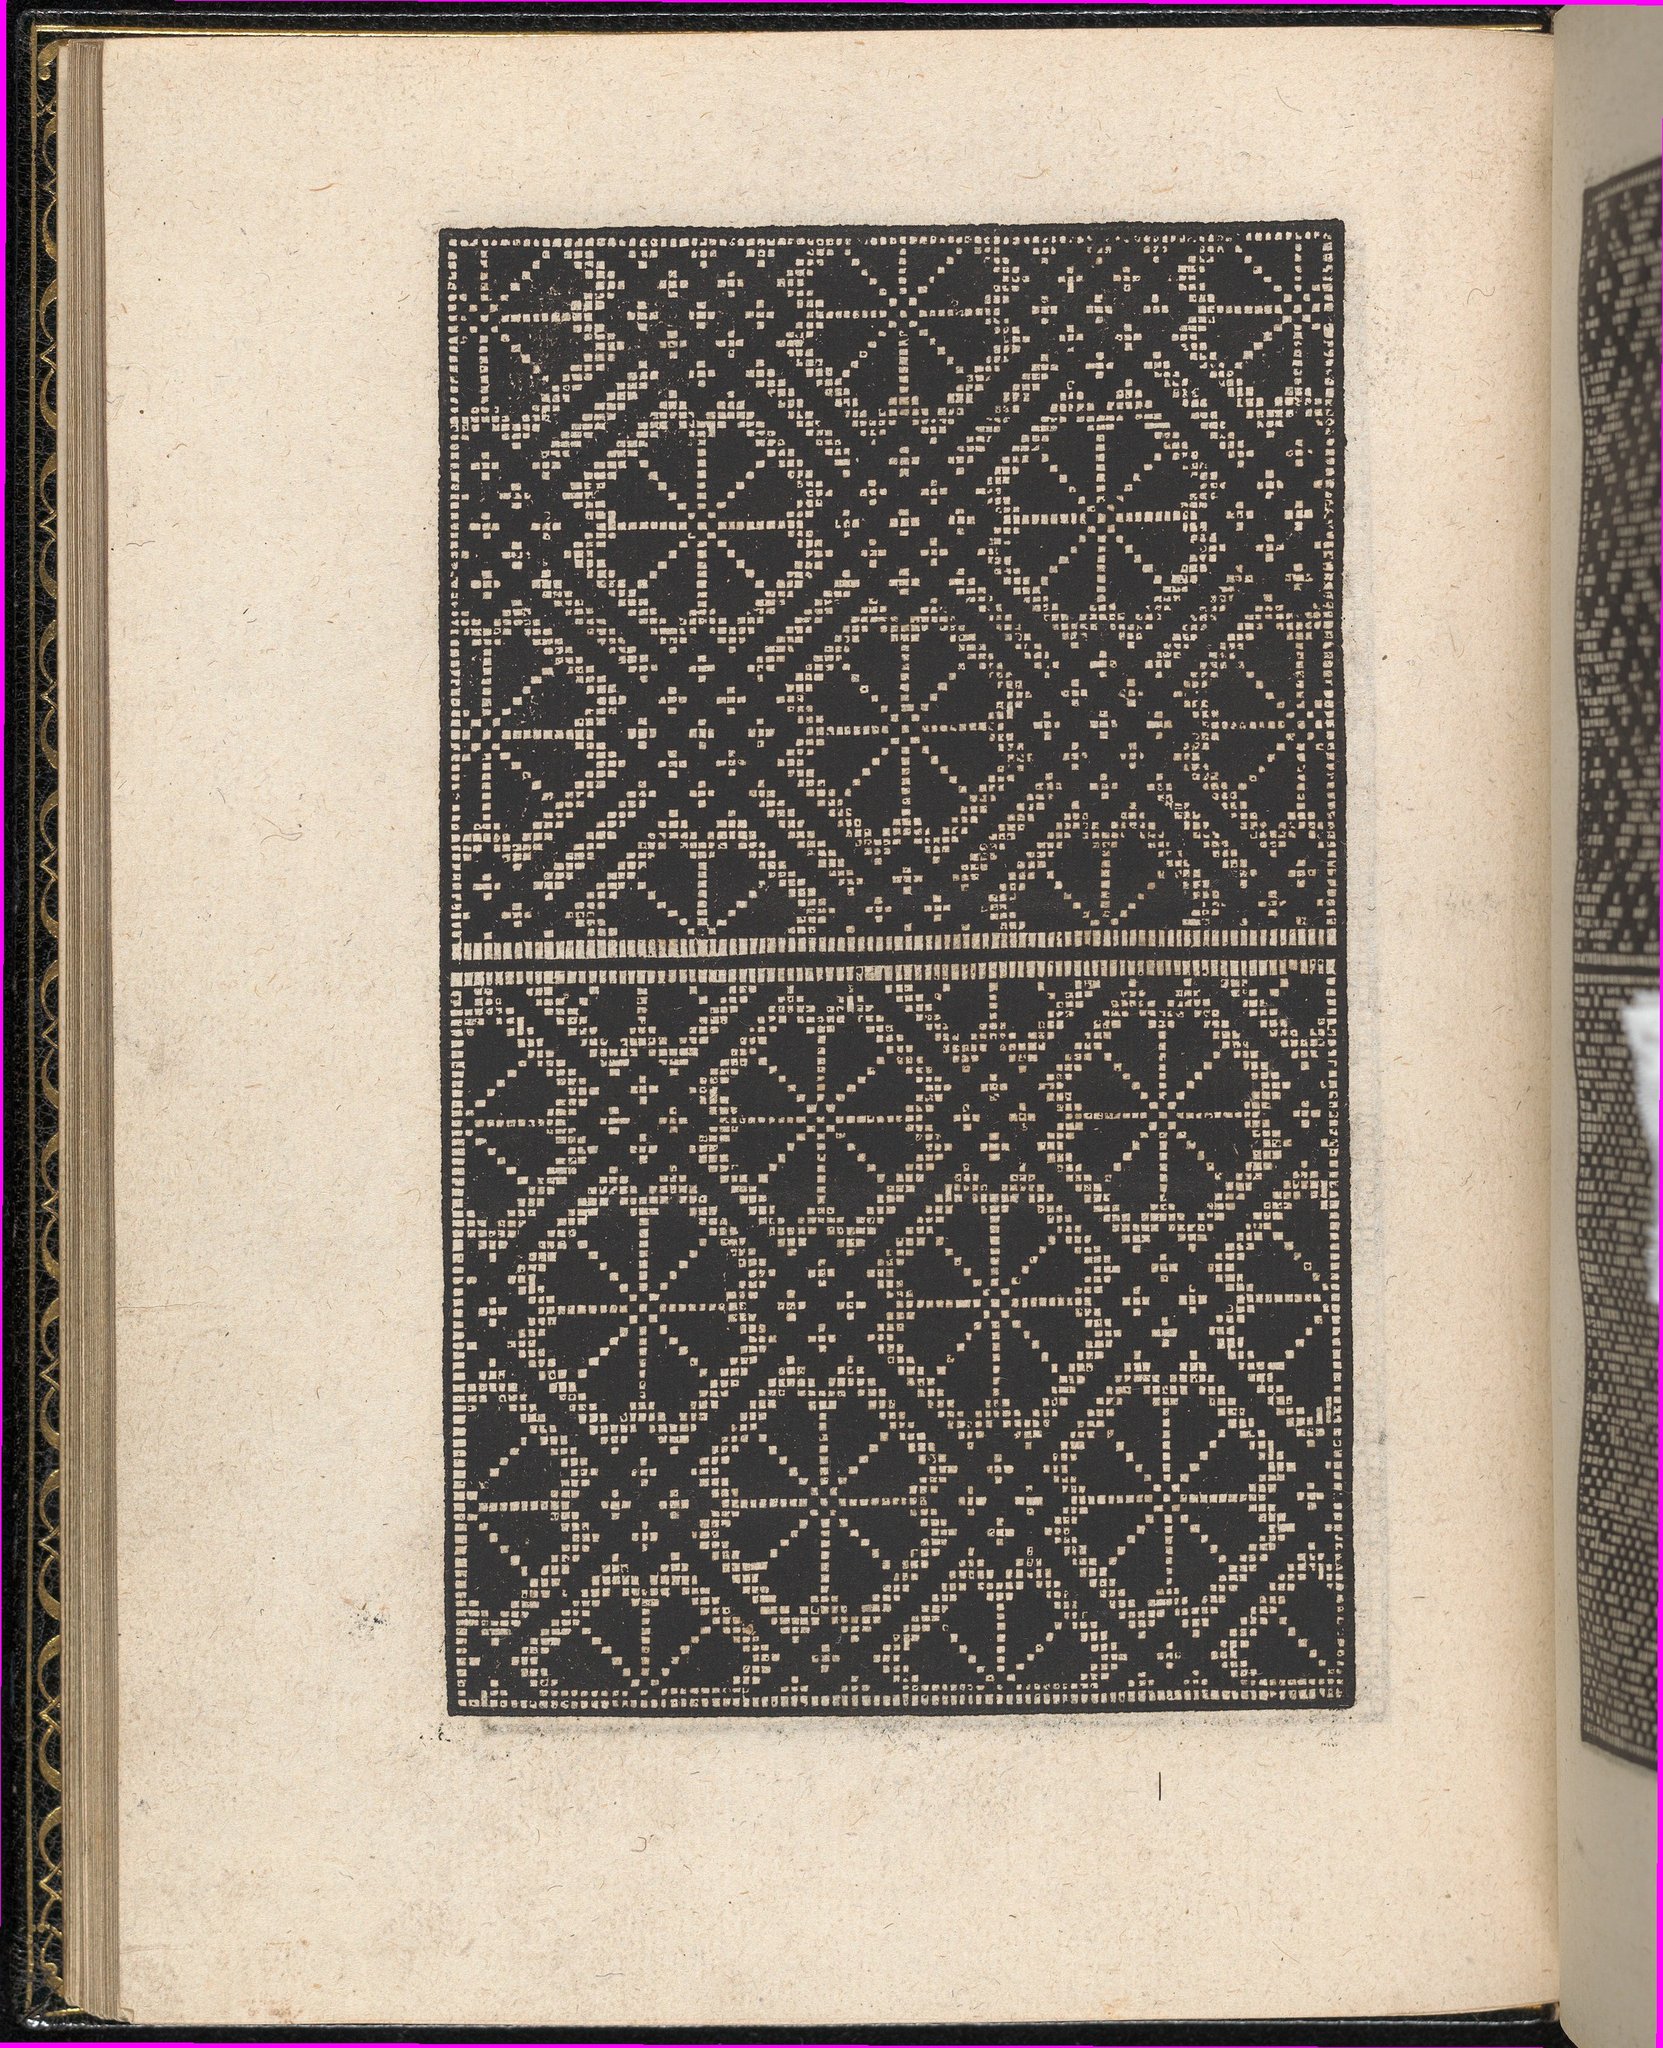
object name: book print ornament architecture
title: Page from Ein new kunstlich Modelbuch...(Page 31v)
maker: peter quentel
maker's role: publisher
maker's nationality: german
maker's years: 1500-1550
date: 1544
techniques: woodcut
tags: ornament